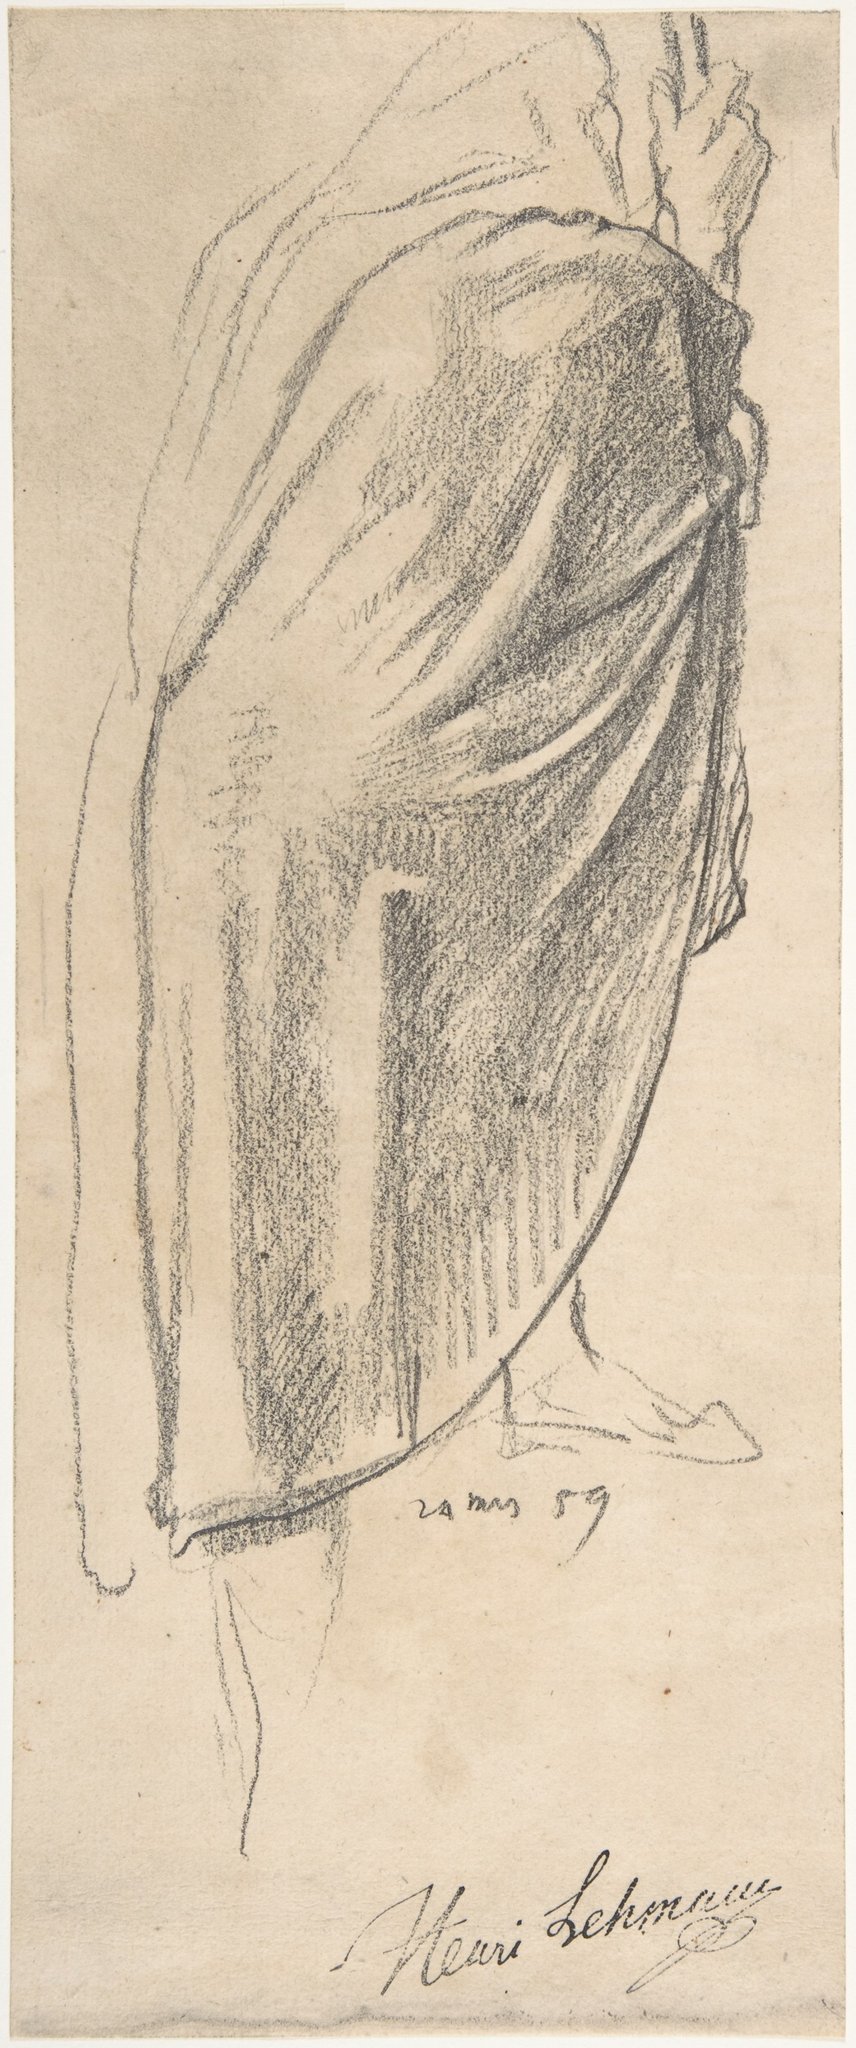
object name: drawing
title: Back View of a Draped Male Figure Holding a Staff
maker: henri lehmann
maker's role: artist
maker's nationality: french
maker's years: 1814-1882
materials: graphite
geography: france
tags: men